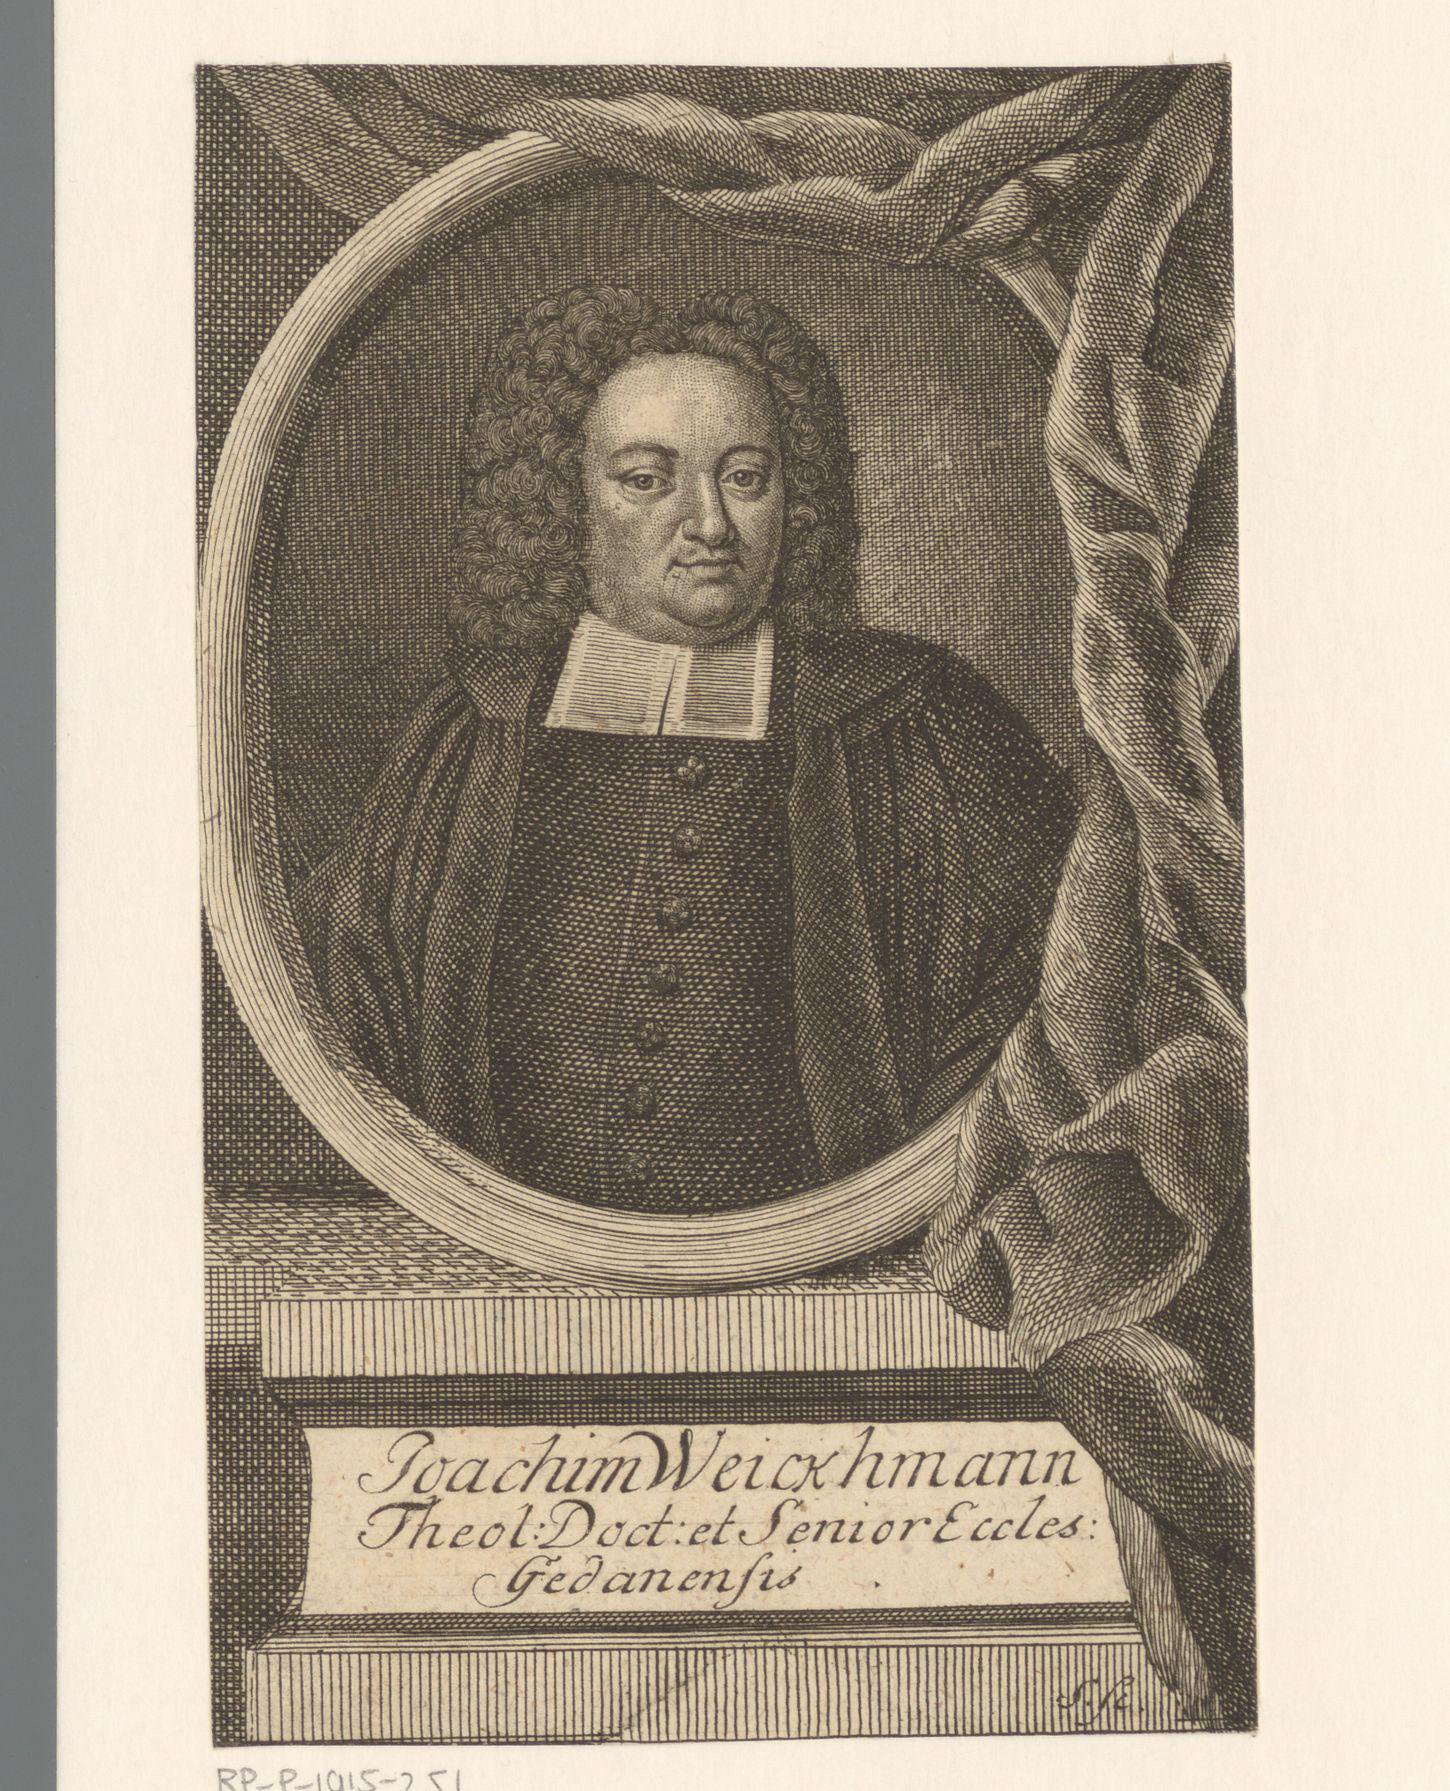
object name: print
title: Portret van Joachim Weickhmann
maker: johann christoph sysang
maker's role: print maker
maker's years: 1703-1757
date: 1713-1757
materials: paper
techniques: engraving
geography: germany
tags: historical persons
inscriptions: collector's mark: Lugt 2228